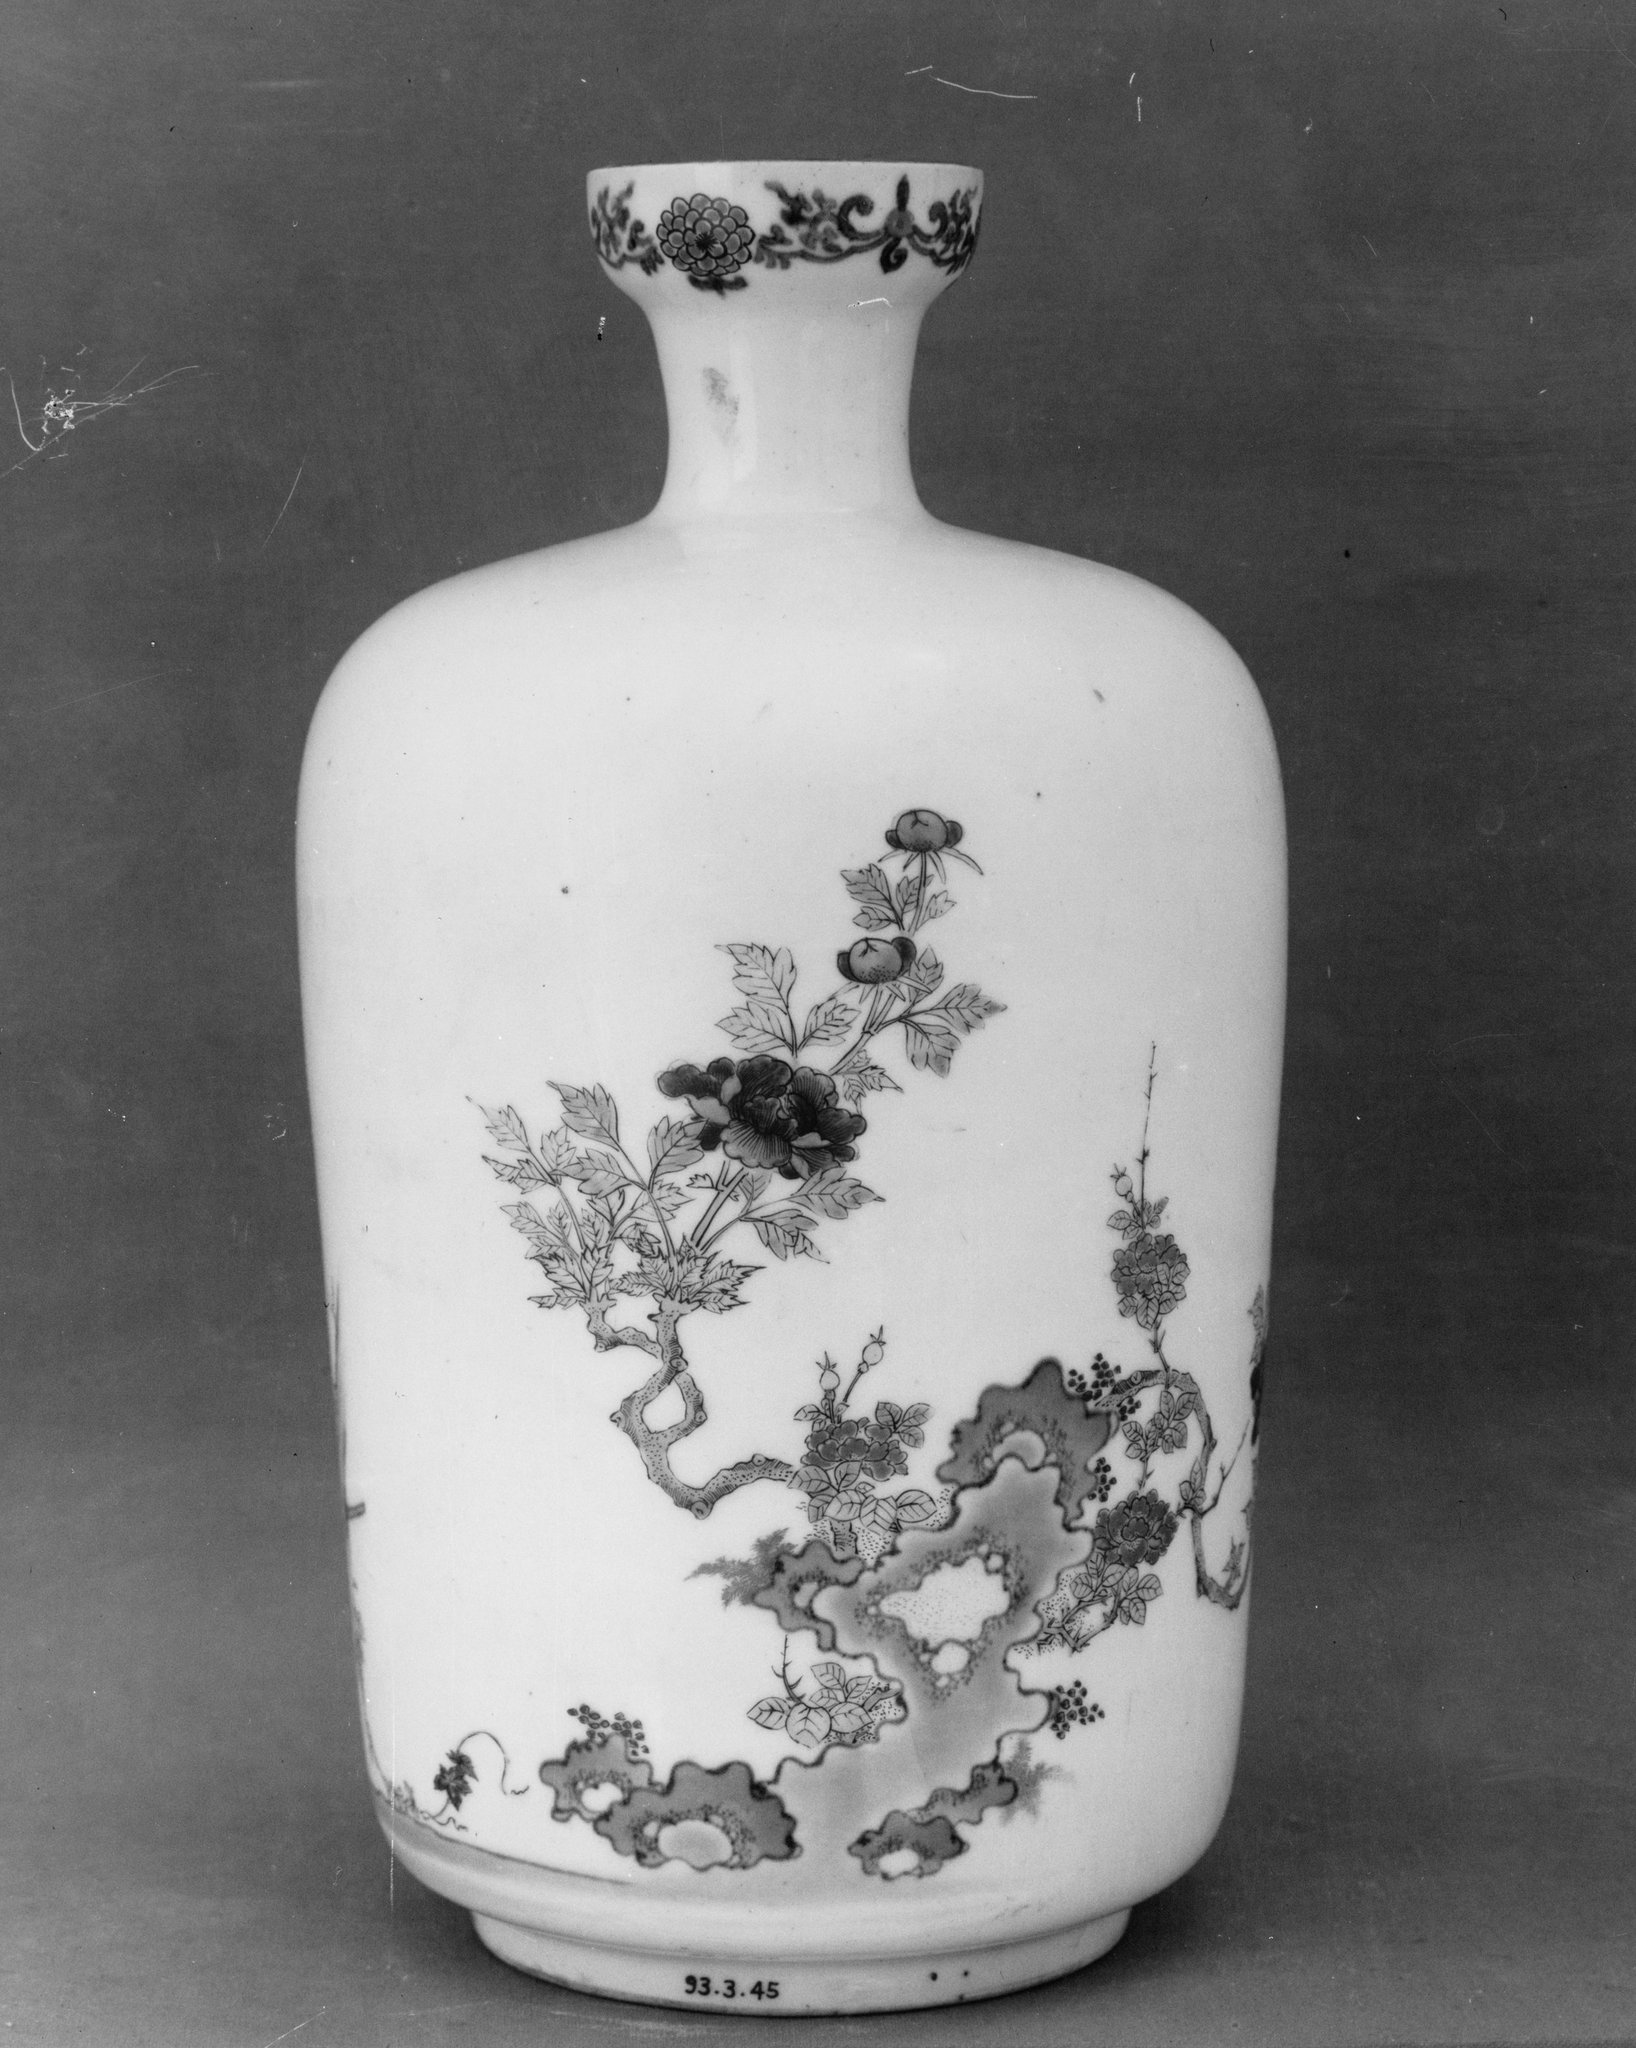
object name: bottle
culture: japanese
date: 1760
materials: enamel, porcelain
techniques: polychrome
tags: leaves